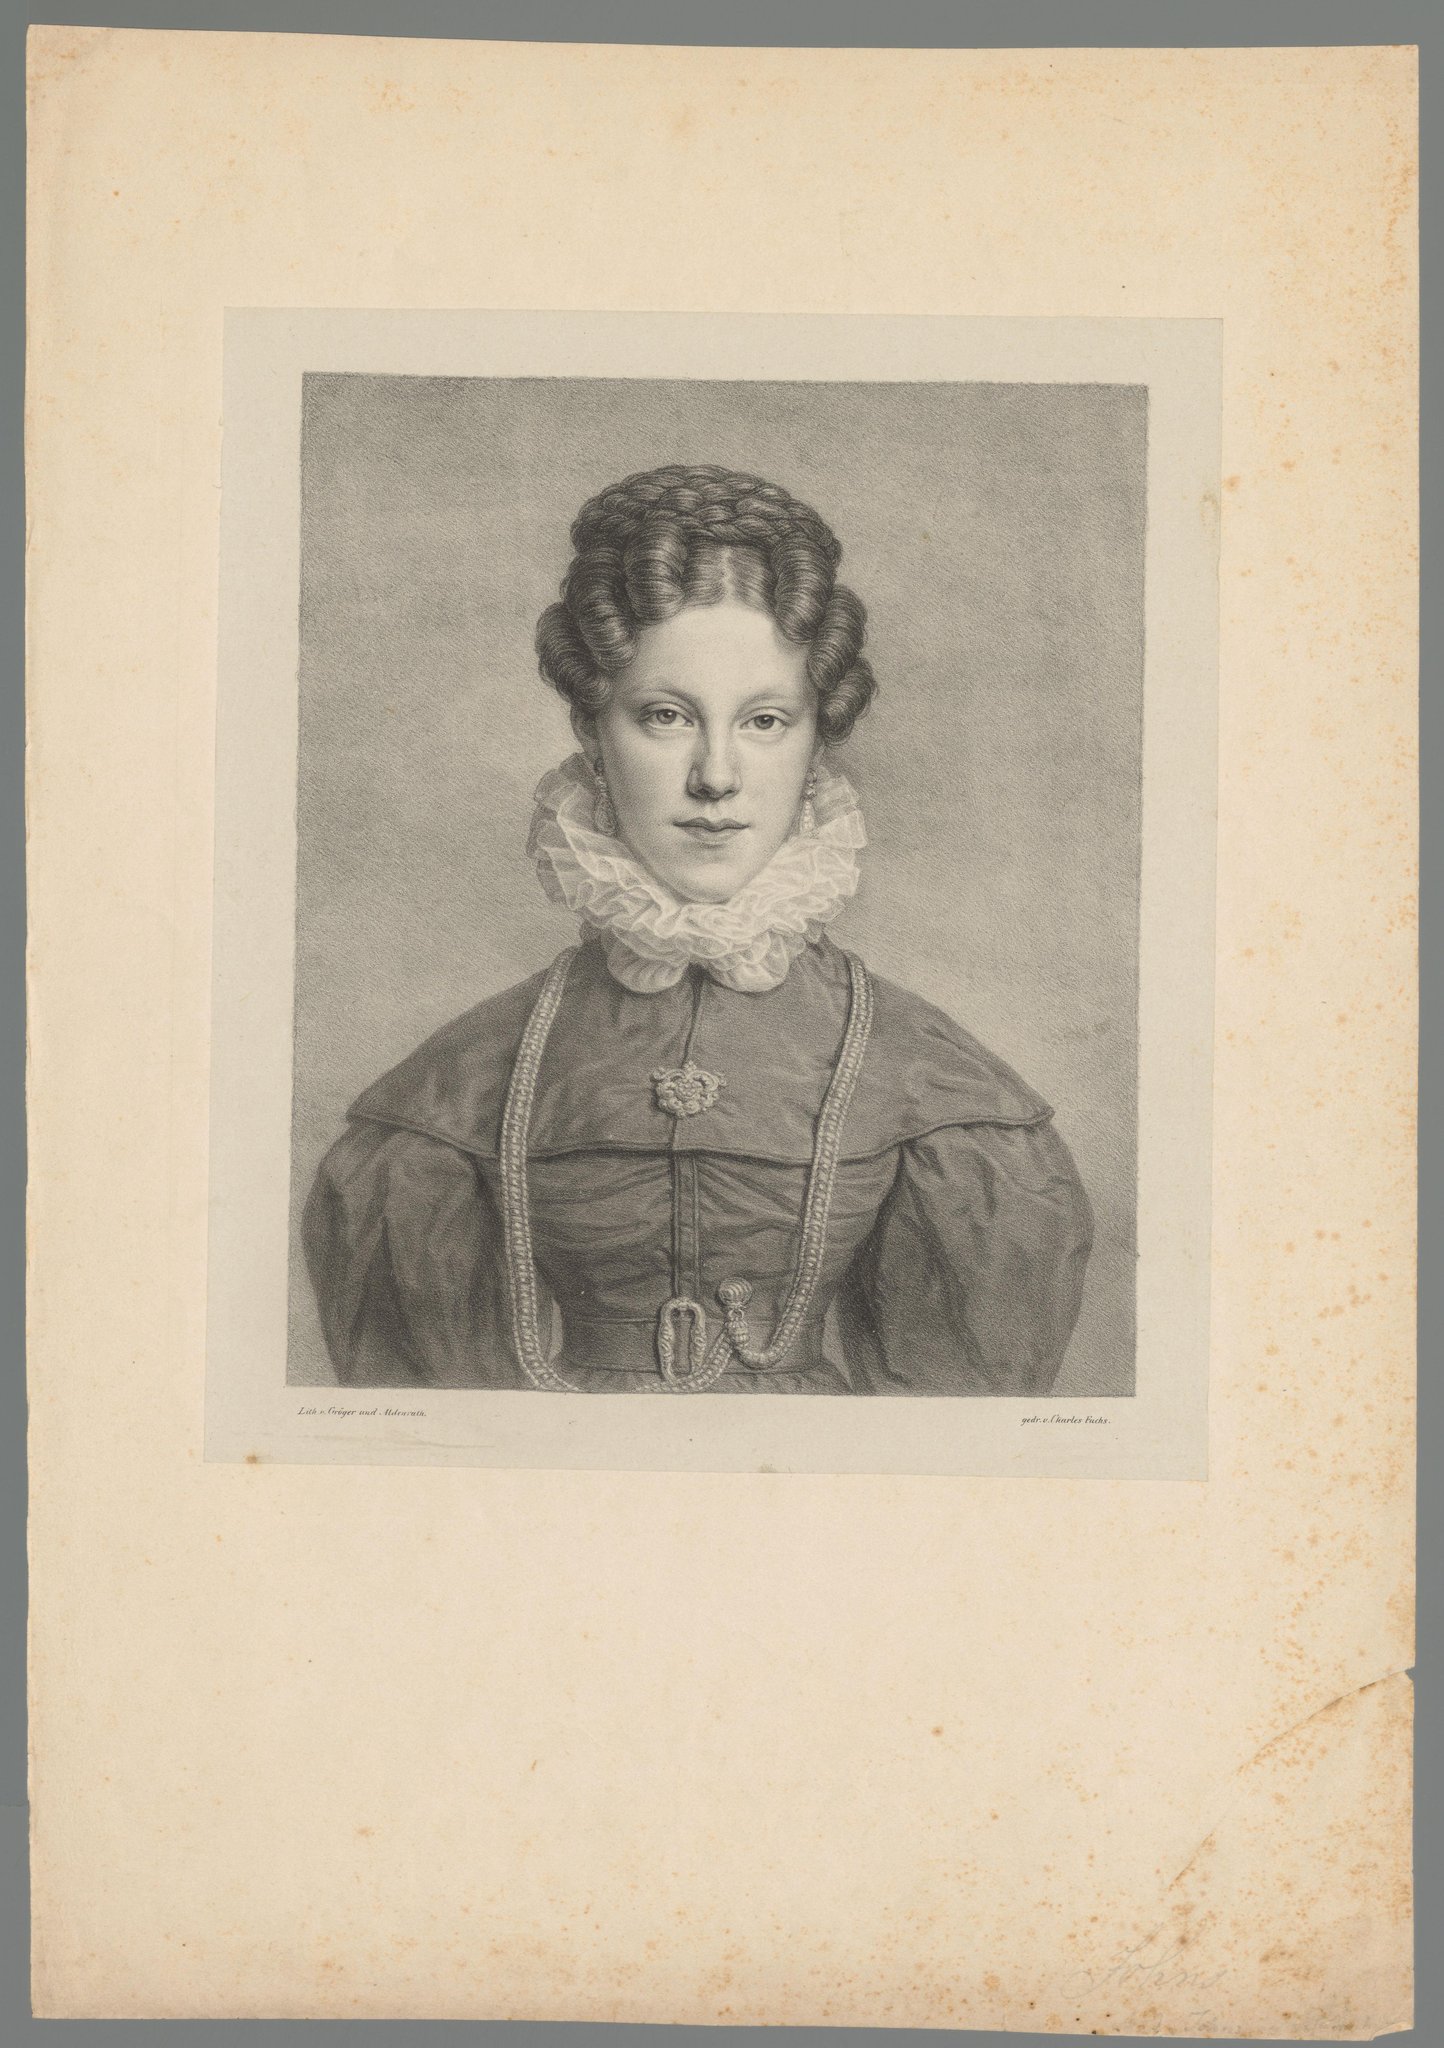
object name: print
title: Portret van een onbekende vrouw, mogelijk Johns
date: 1800-1838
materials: paper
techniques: lithograph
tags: adult woman, historical persons, neck-gear: collar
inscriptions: collector's mark: Lugt 2228